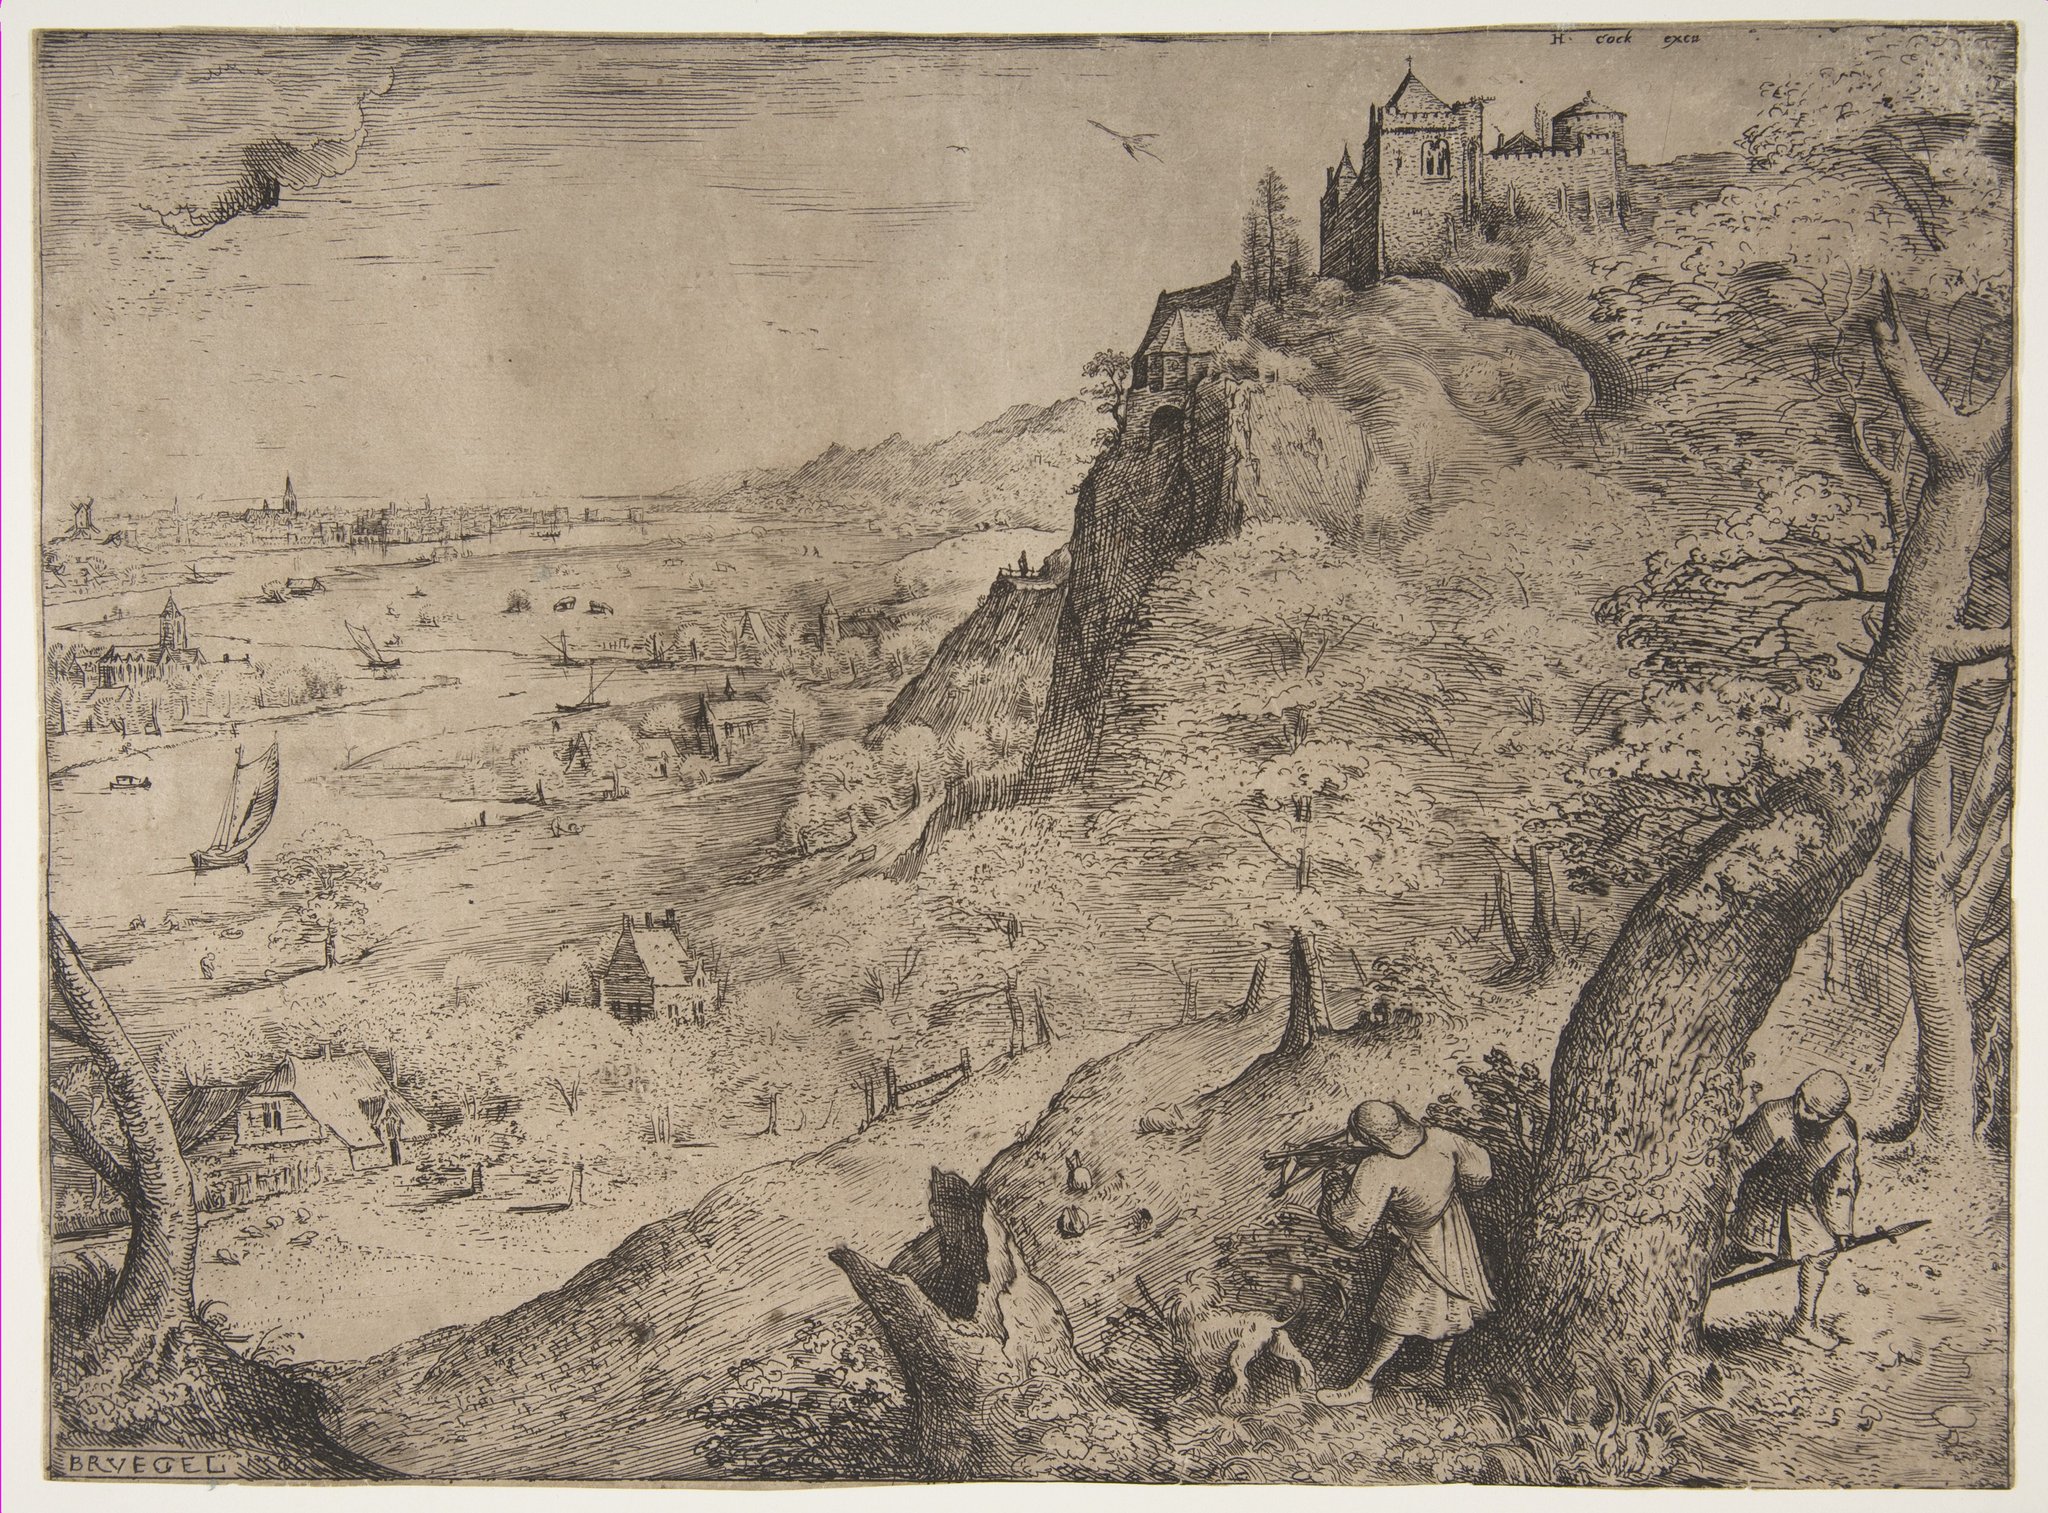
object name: print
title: The Rabbit Hunt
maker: pieter bruegel the elder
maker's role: artist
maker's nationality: netherlandish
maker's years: 1525-1569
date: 1560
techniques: etching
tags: men,hunting,rabbits,landscapes